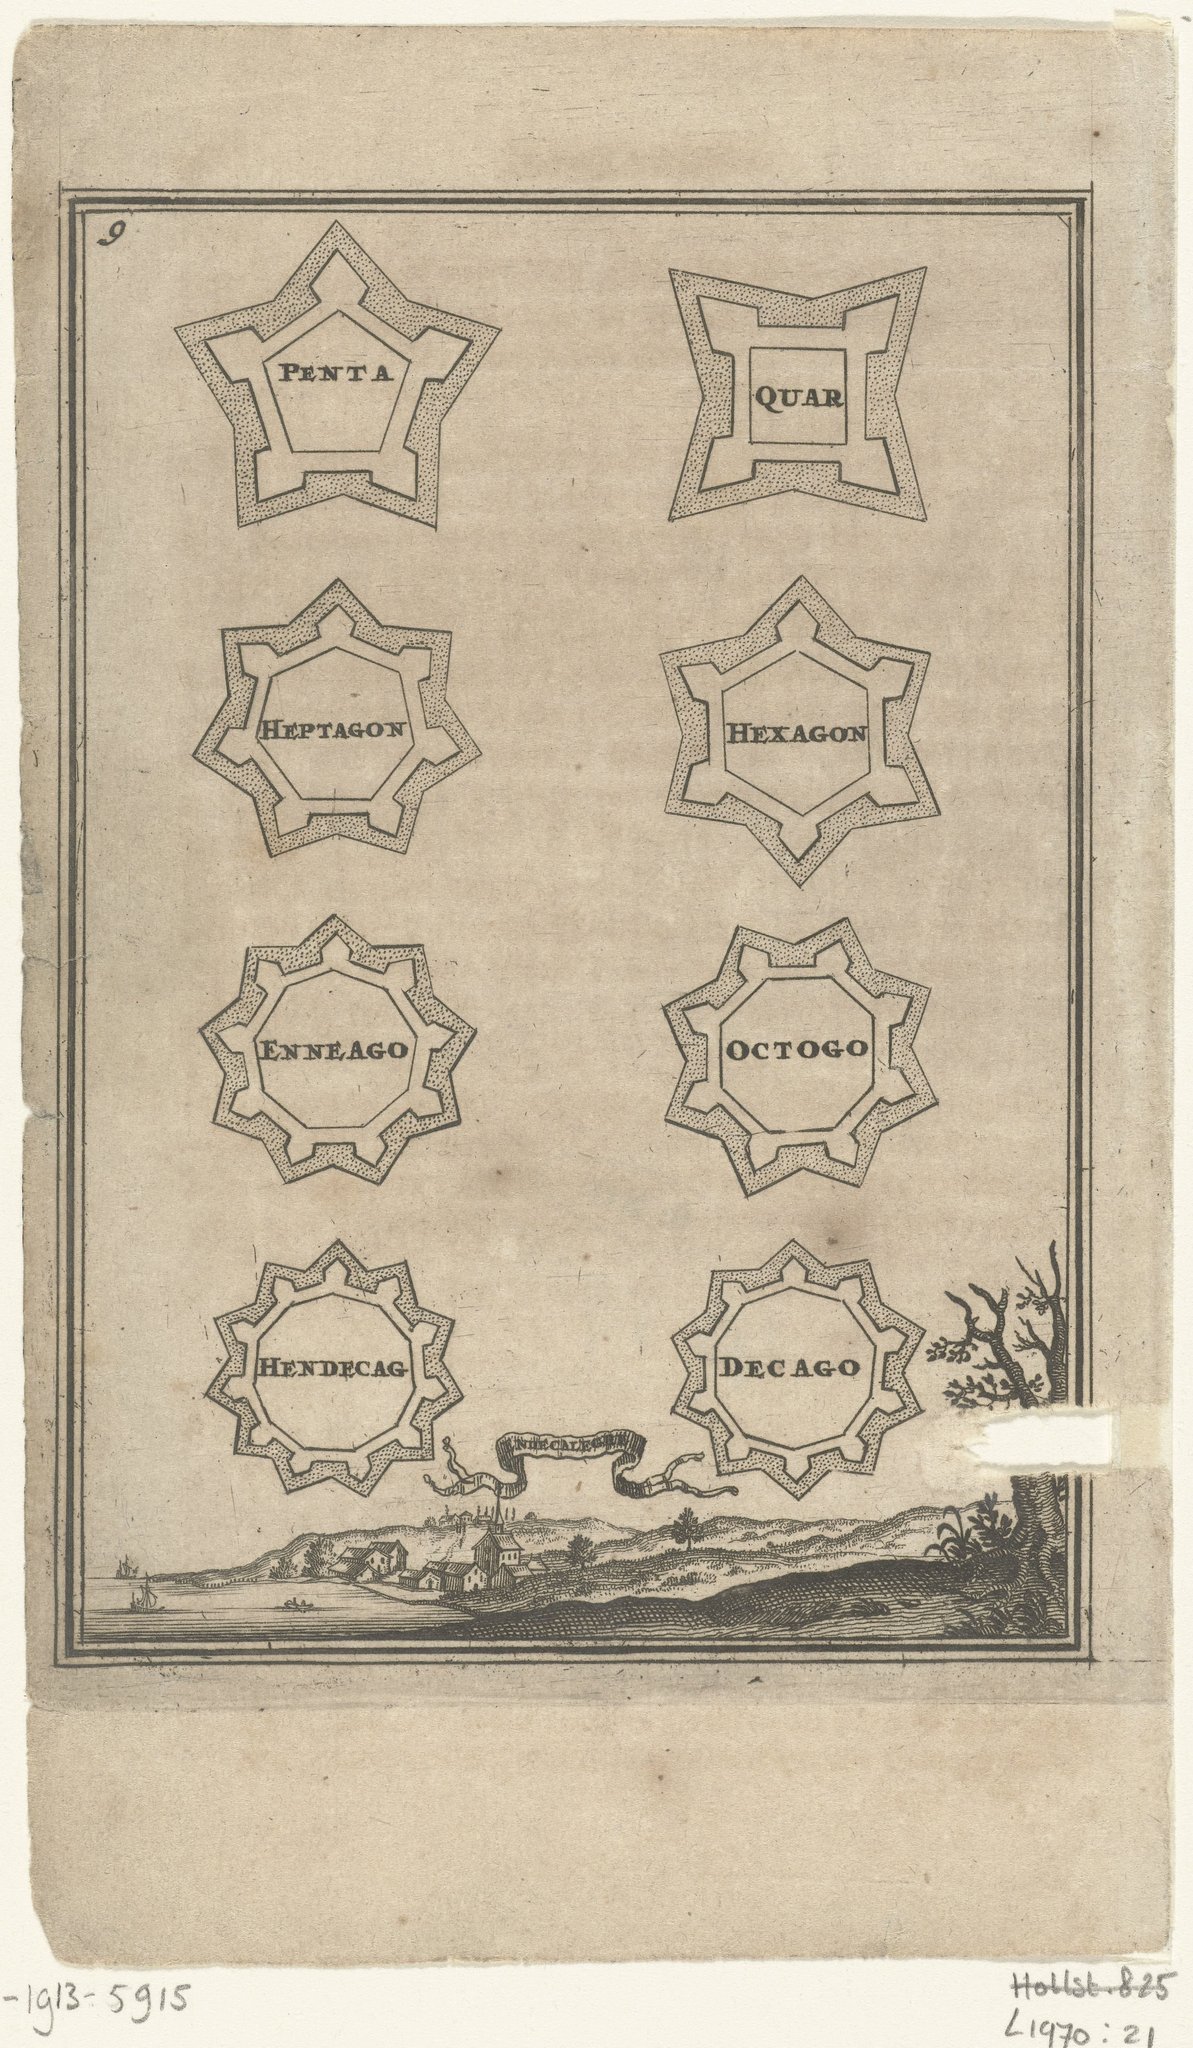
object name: print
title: Illustratie voor 'Den Arbeid van Mars' van Allain Manesson Mallet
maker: romeyn de hooghe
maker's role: draughtsman, goldsmith, painter, print maker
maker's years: 1645-1708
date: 1672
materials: paper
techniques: etching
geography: amsterdam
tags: landscapes with waters, waterscapes, seascapes (in the temperate zone), village, fortifications, military engineering, mathematics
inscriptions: collector's mark: Lugt 2228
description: Acht grondplannen voor vestingen, forten of versterkingen. Daaronder een gezicht op een dorp aan een water. In de hoek linksboven het cijfer 9 (= het nummer van de pagina in het boek waartegenover de illustratie geplaatst is).